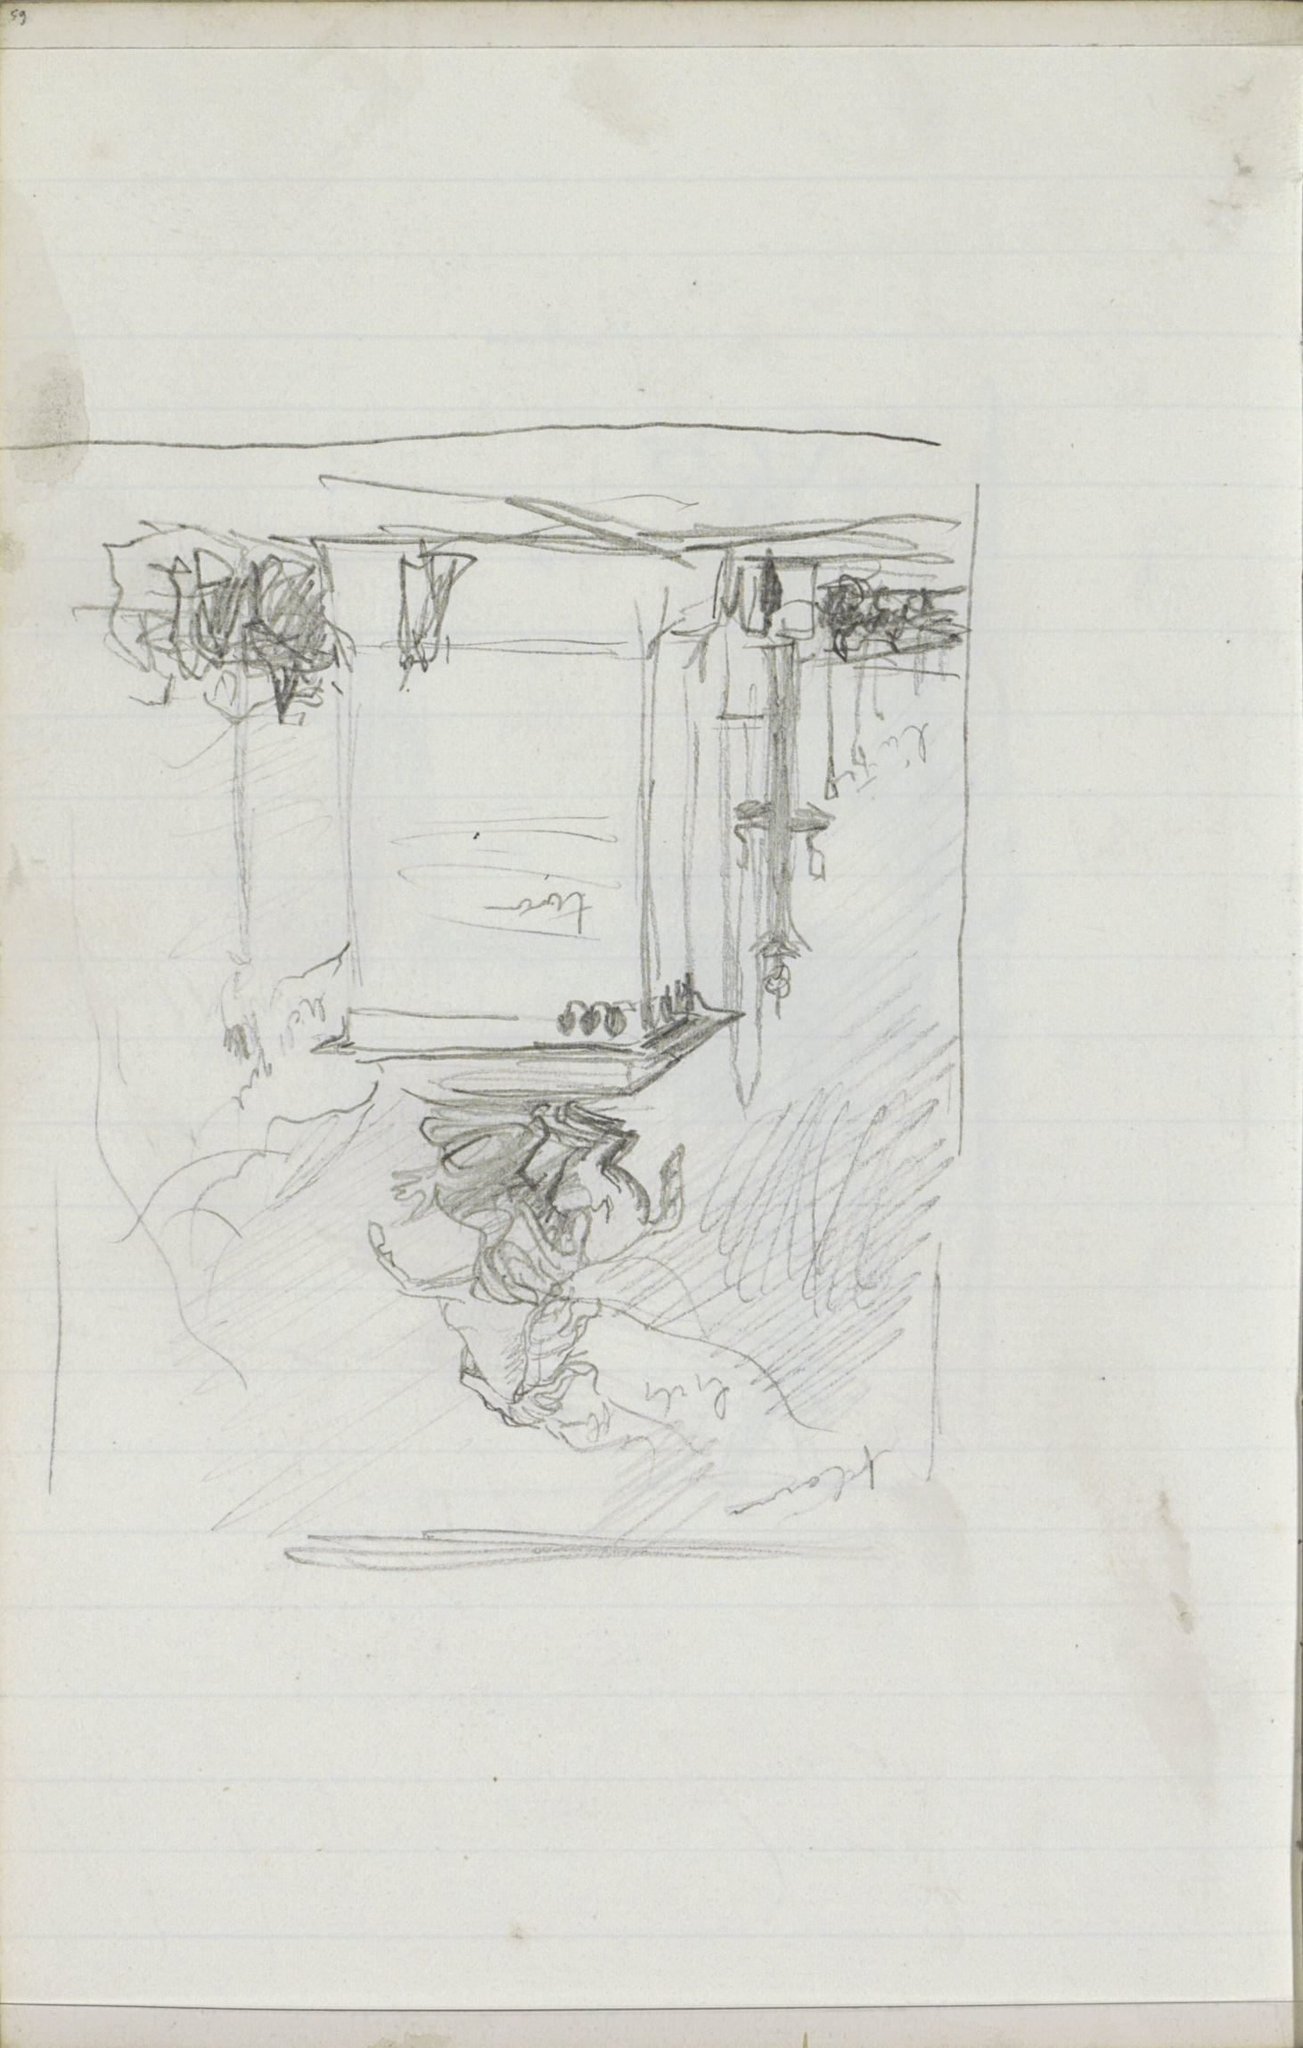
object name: sketchbook leaf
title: Beeld van het Paard van Marly aan de voet van de Champs-Elysées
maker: marius bauer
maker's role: draughtsman, print maker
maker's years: 1867-1932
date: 1877-1932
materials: pencil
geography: paris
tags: obelisk, needle, monument, statue, horse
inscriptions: kleurnotitie, handgeschreven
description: Het beeld werd gemaakt door Guillaume I Coustou in 1739-45, in opdracht van Louis XIV en was oorspronkelijk (met pendanten) bedoeld voor Château de Marly. In 1749 werd het beeld verplaatst naar de voet van de Champs-Elysées.